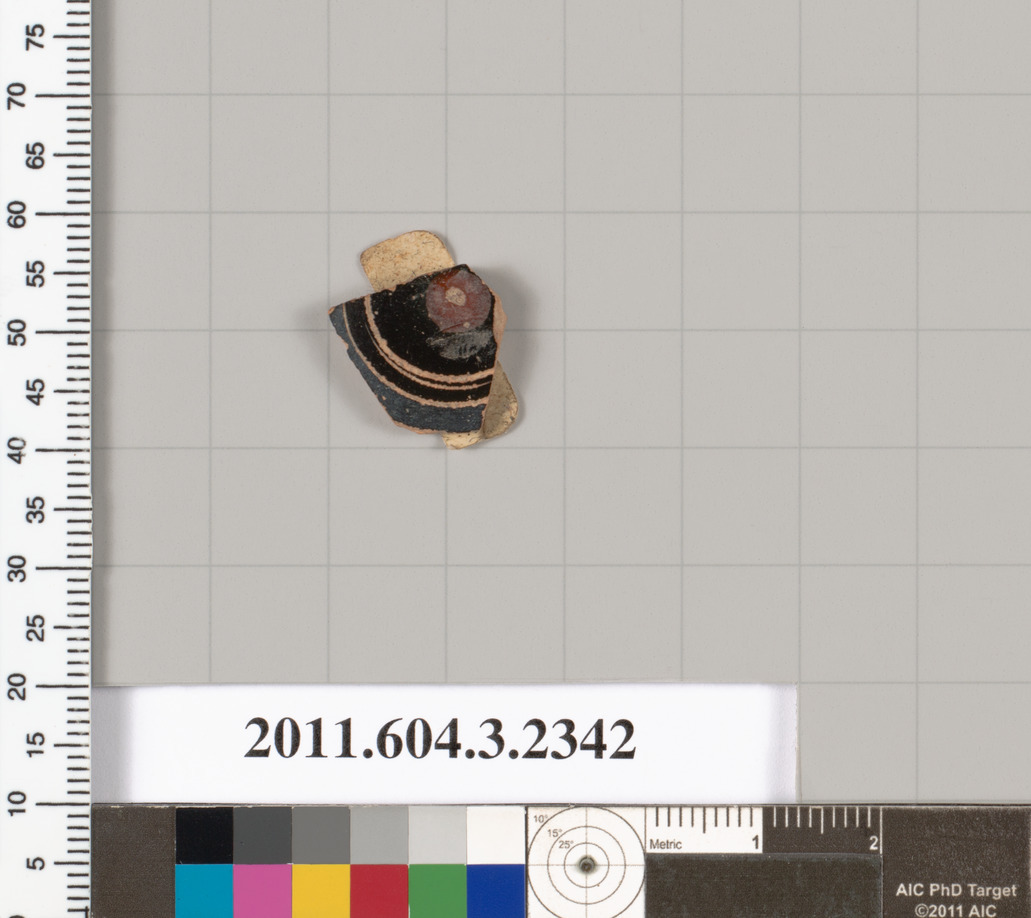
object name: kylix fragment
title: Terracotta fragment of a kylix: eye-cup (drinking cup)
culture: greek, attic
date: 540-520 BCE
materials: terracotta